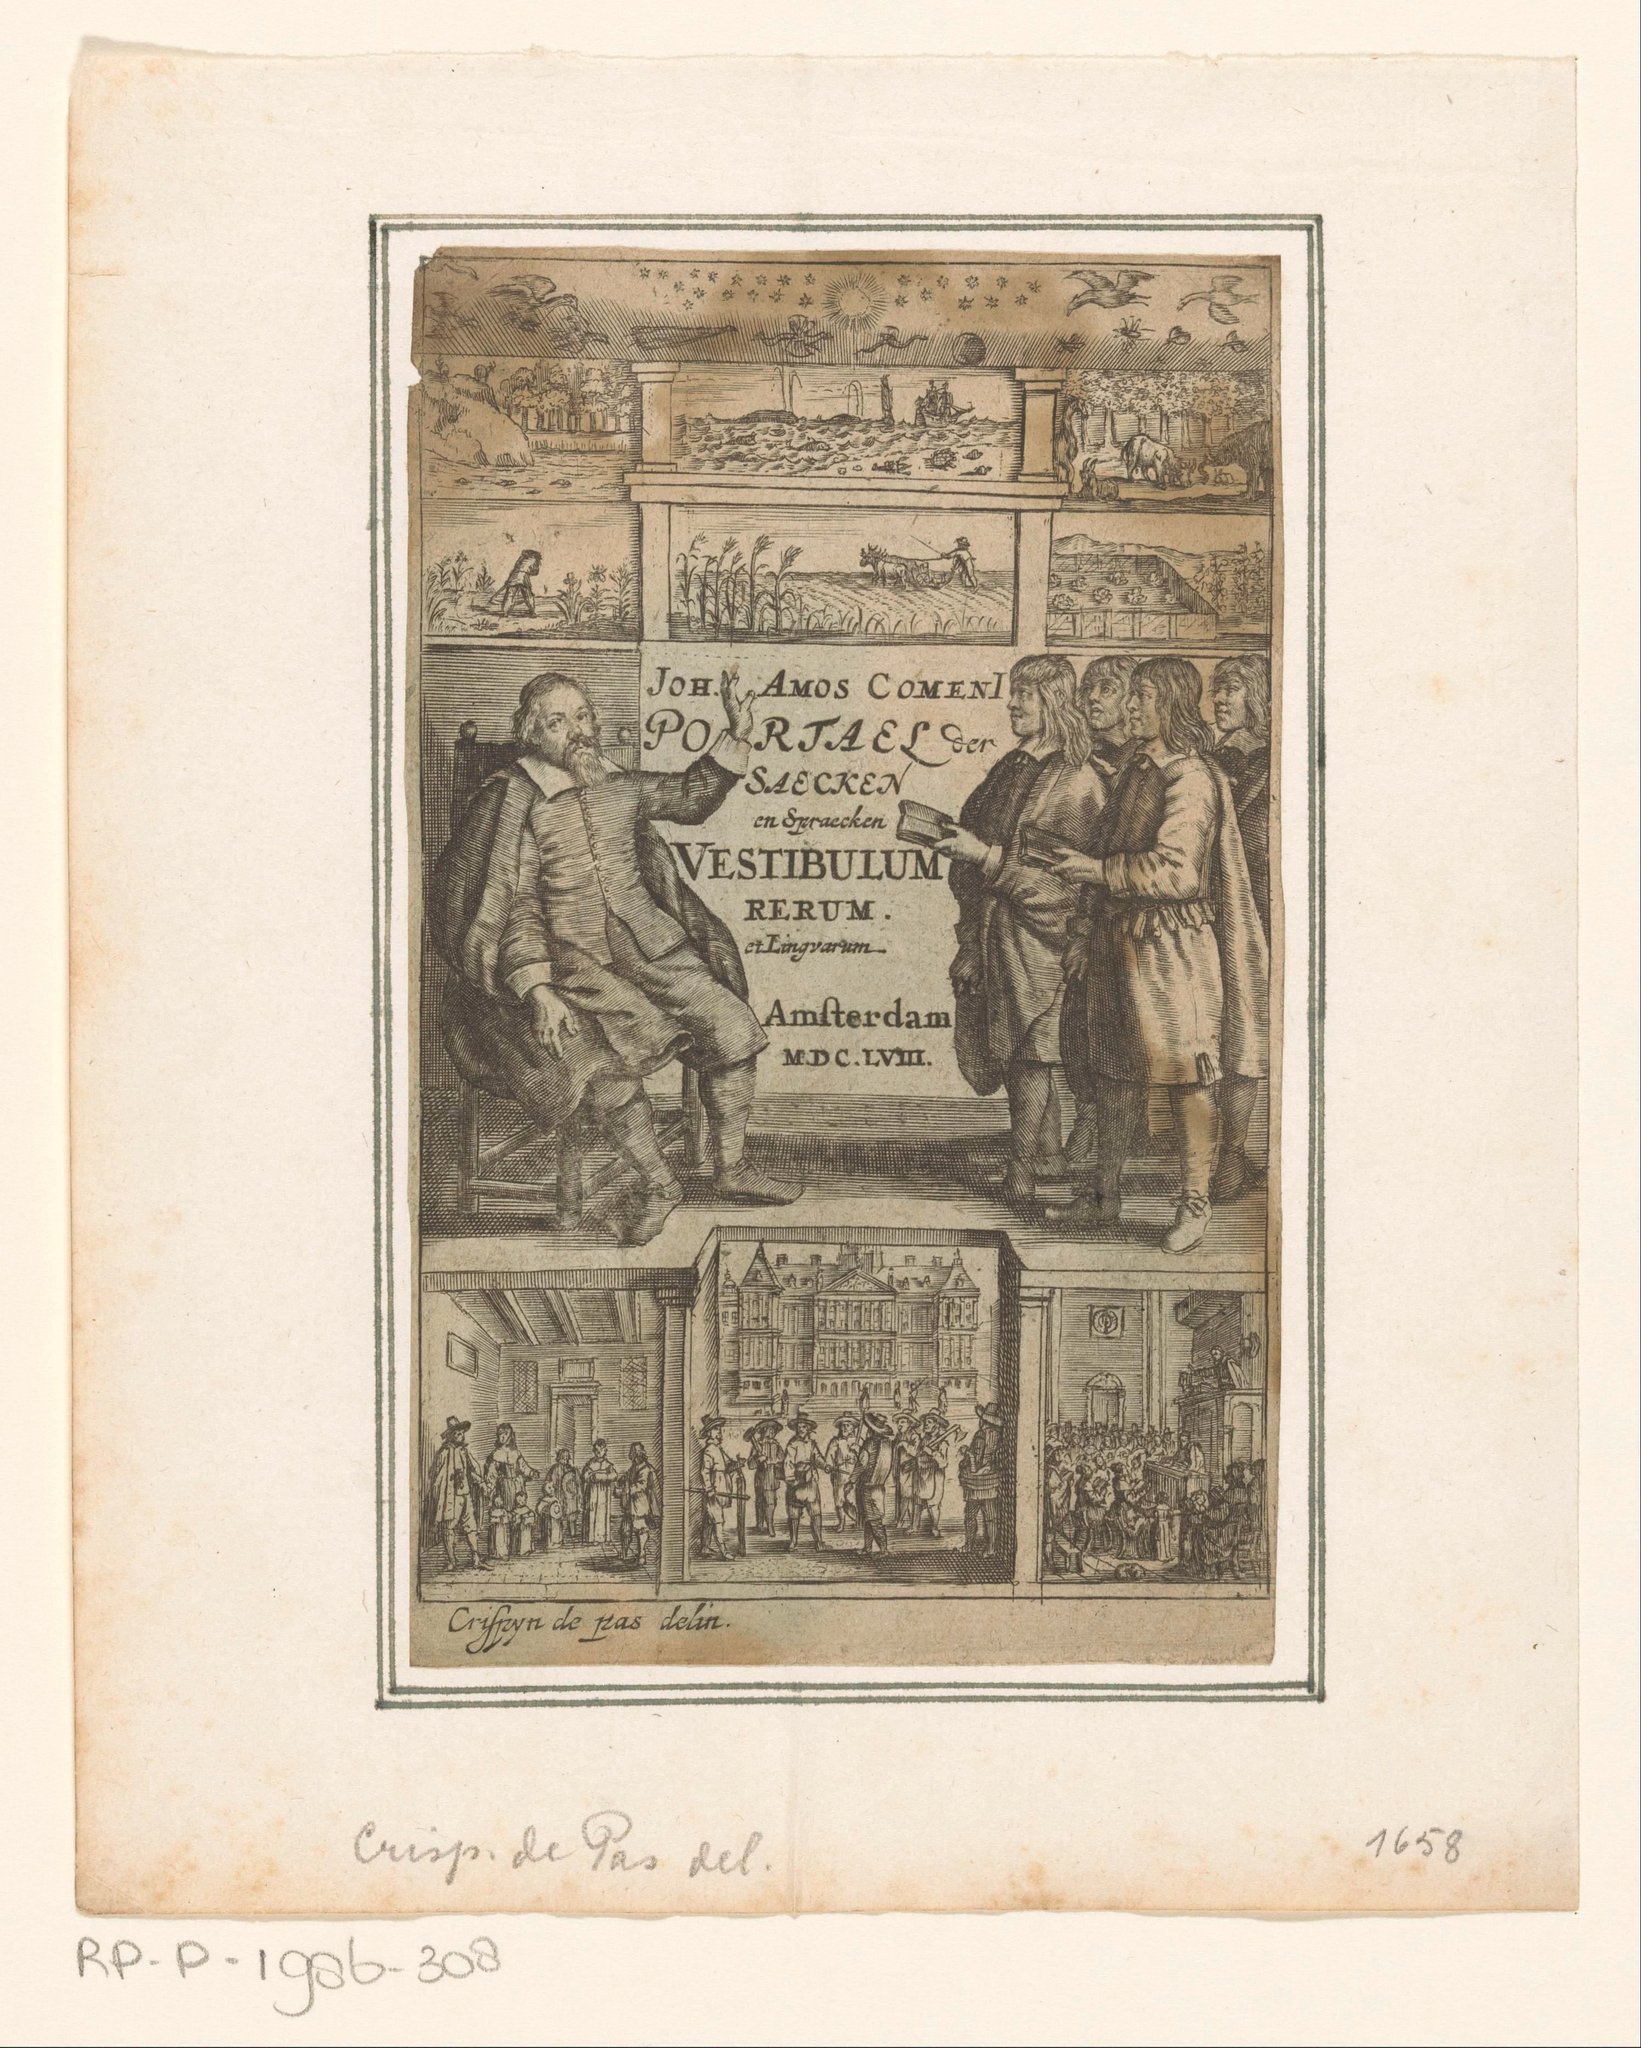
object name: titelblad, titelpagina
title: Titelpagina voor: Jan Amos Comenius, Portael der Saecken en Spraecken Vestibulum rerum et Linguarum, 1658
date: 1658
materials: paper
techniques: engraving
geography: amsterdam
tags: amsterdam, writer, poet, author, student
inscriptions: collector's mark: Lugt 2228, collector's mark: Lugt 2760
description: Schrijver Comenius zit op een stoel met rechts een groep leerlingen. Hij wijst met zijn linkerhand naar afbeeldingen met landschappen en dieren boven hen. Met zijn rechterhand wijst hij op drie scènes uit het dagelijks leven: Een gezin in een interieur; een redenaar op een marktplein en een predikant tijdens een kerkdienst.